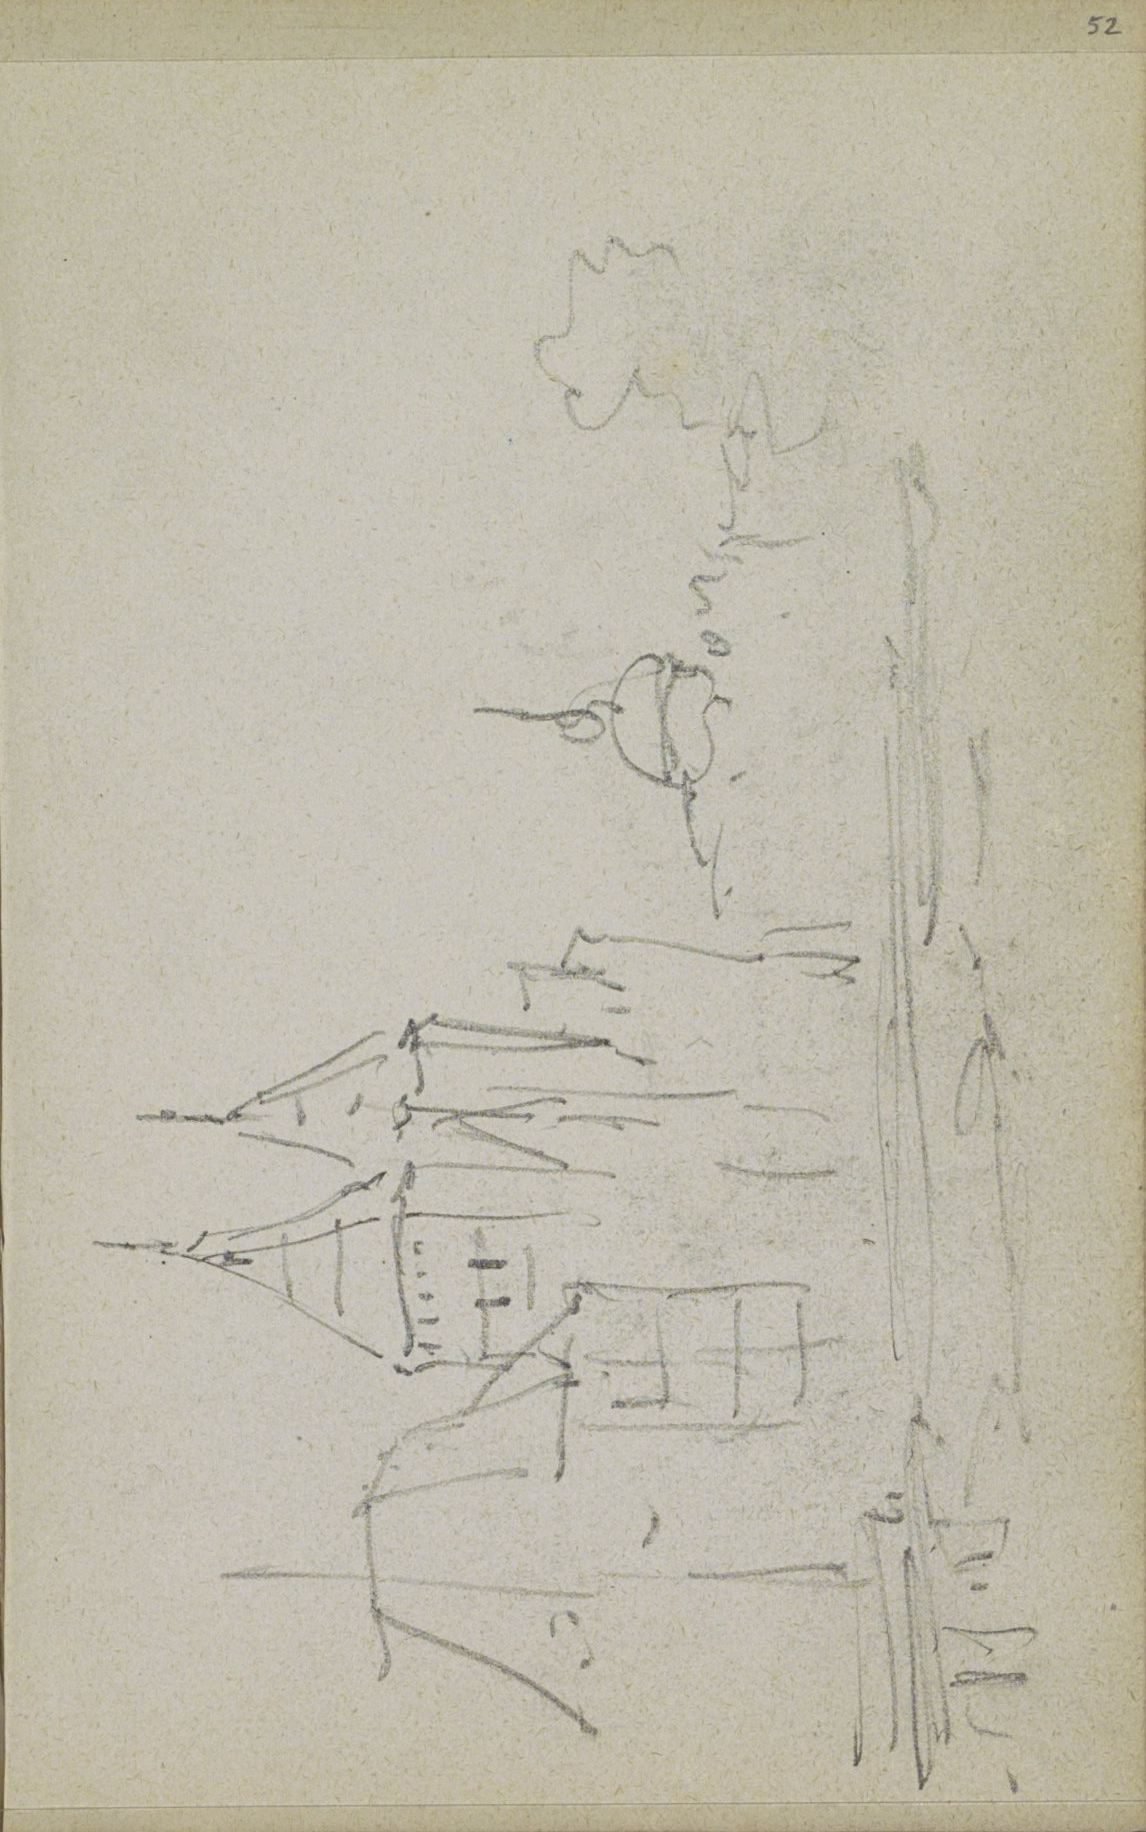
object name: sketchbook leaf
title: Gezicht op de Stadhouderskade met het Rijksmuseum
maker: adrianus eversen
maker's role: draughtsman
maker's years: 1818-1897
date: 1828-1897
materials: paper, pencil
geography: netherlands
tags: canal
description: Links het Rijksmuseum, gezien vanaf de Stadhouderskade. Linksvoor mogelijk een boot. Rechts in de verte een koepel. Blad 52 recto uit een schetsboek met 58 bladen.